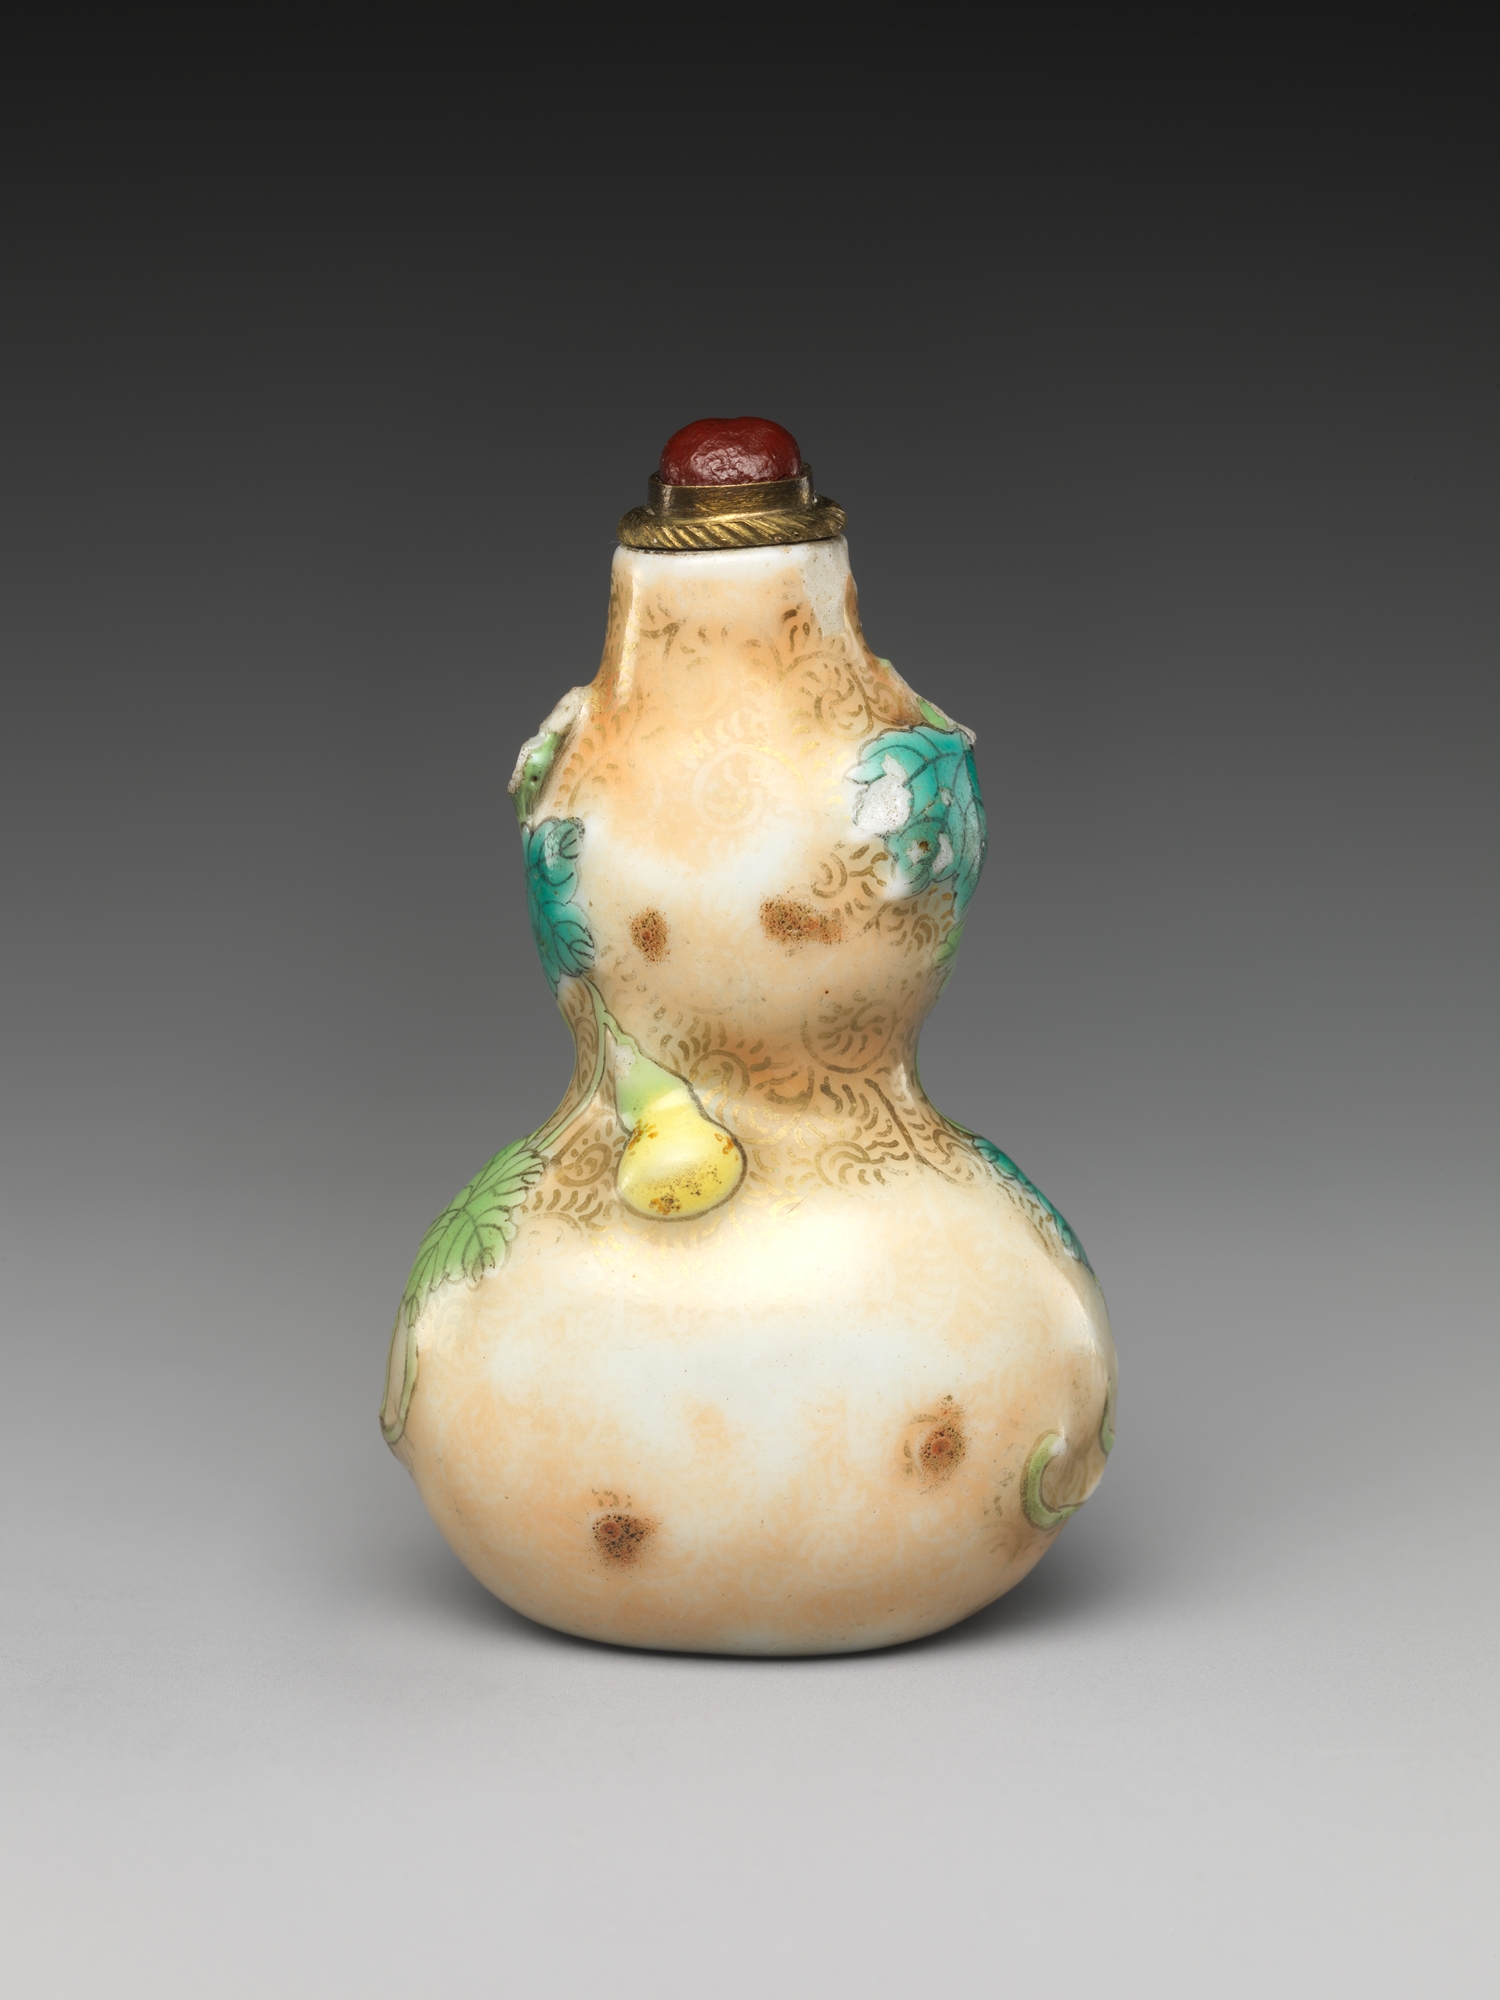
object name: snuff bottle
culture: chinese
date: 1801-1900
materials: porcelain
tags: gourds